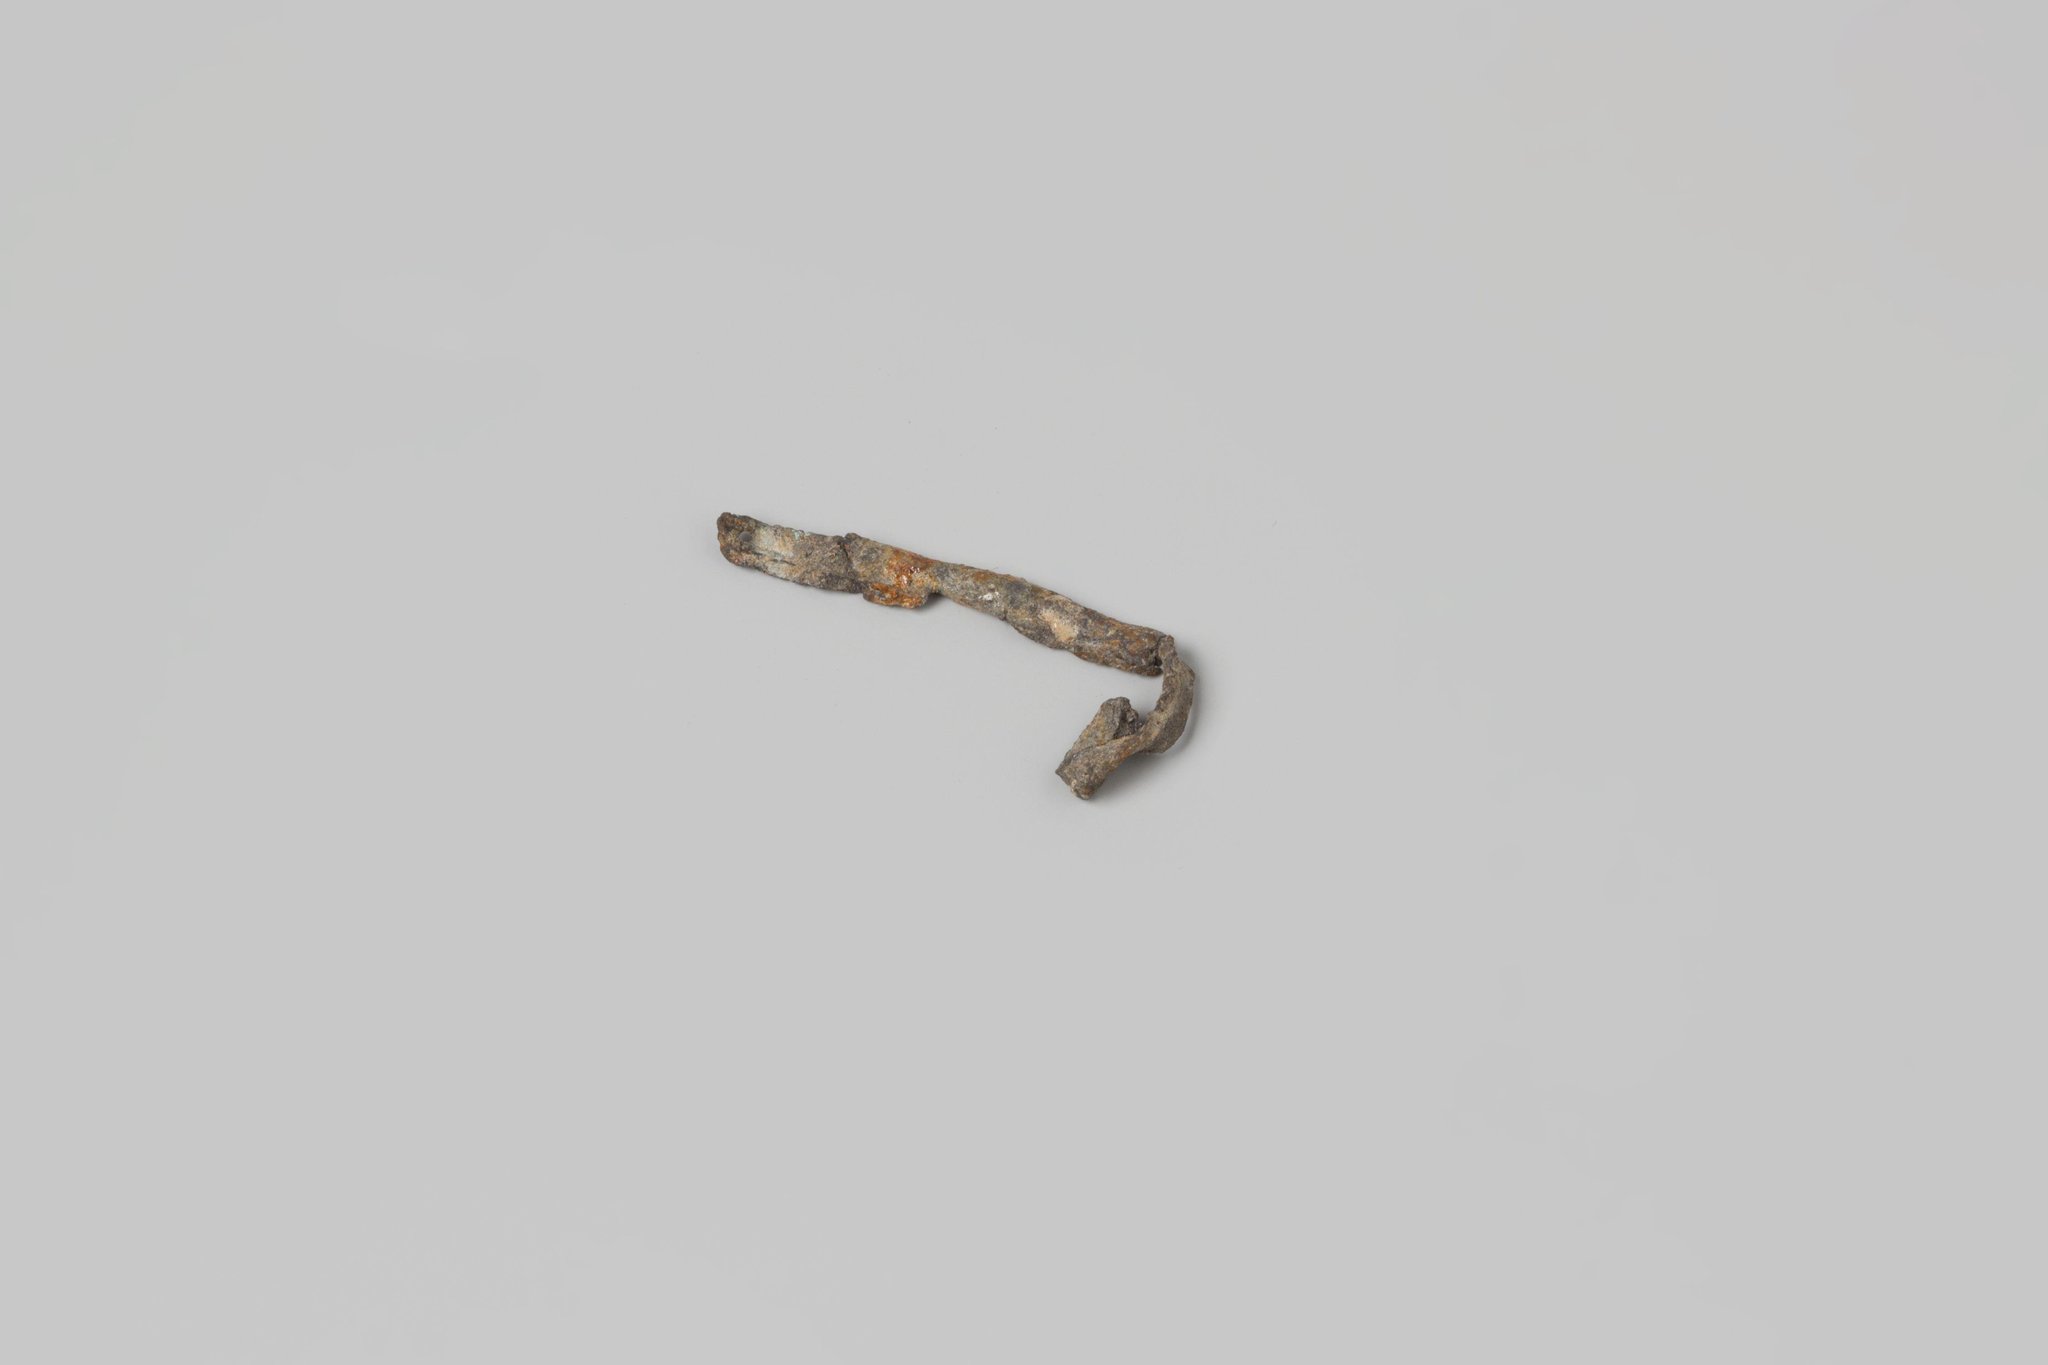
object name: fragment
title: Fragment tin uit het wrak van de Oost-Indiëvaarder Hollandia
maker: Anonymous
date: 1700-1743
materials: tin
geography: netherlands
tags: verenigde oostindische compagnie, hollandia (schip), annet